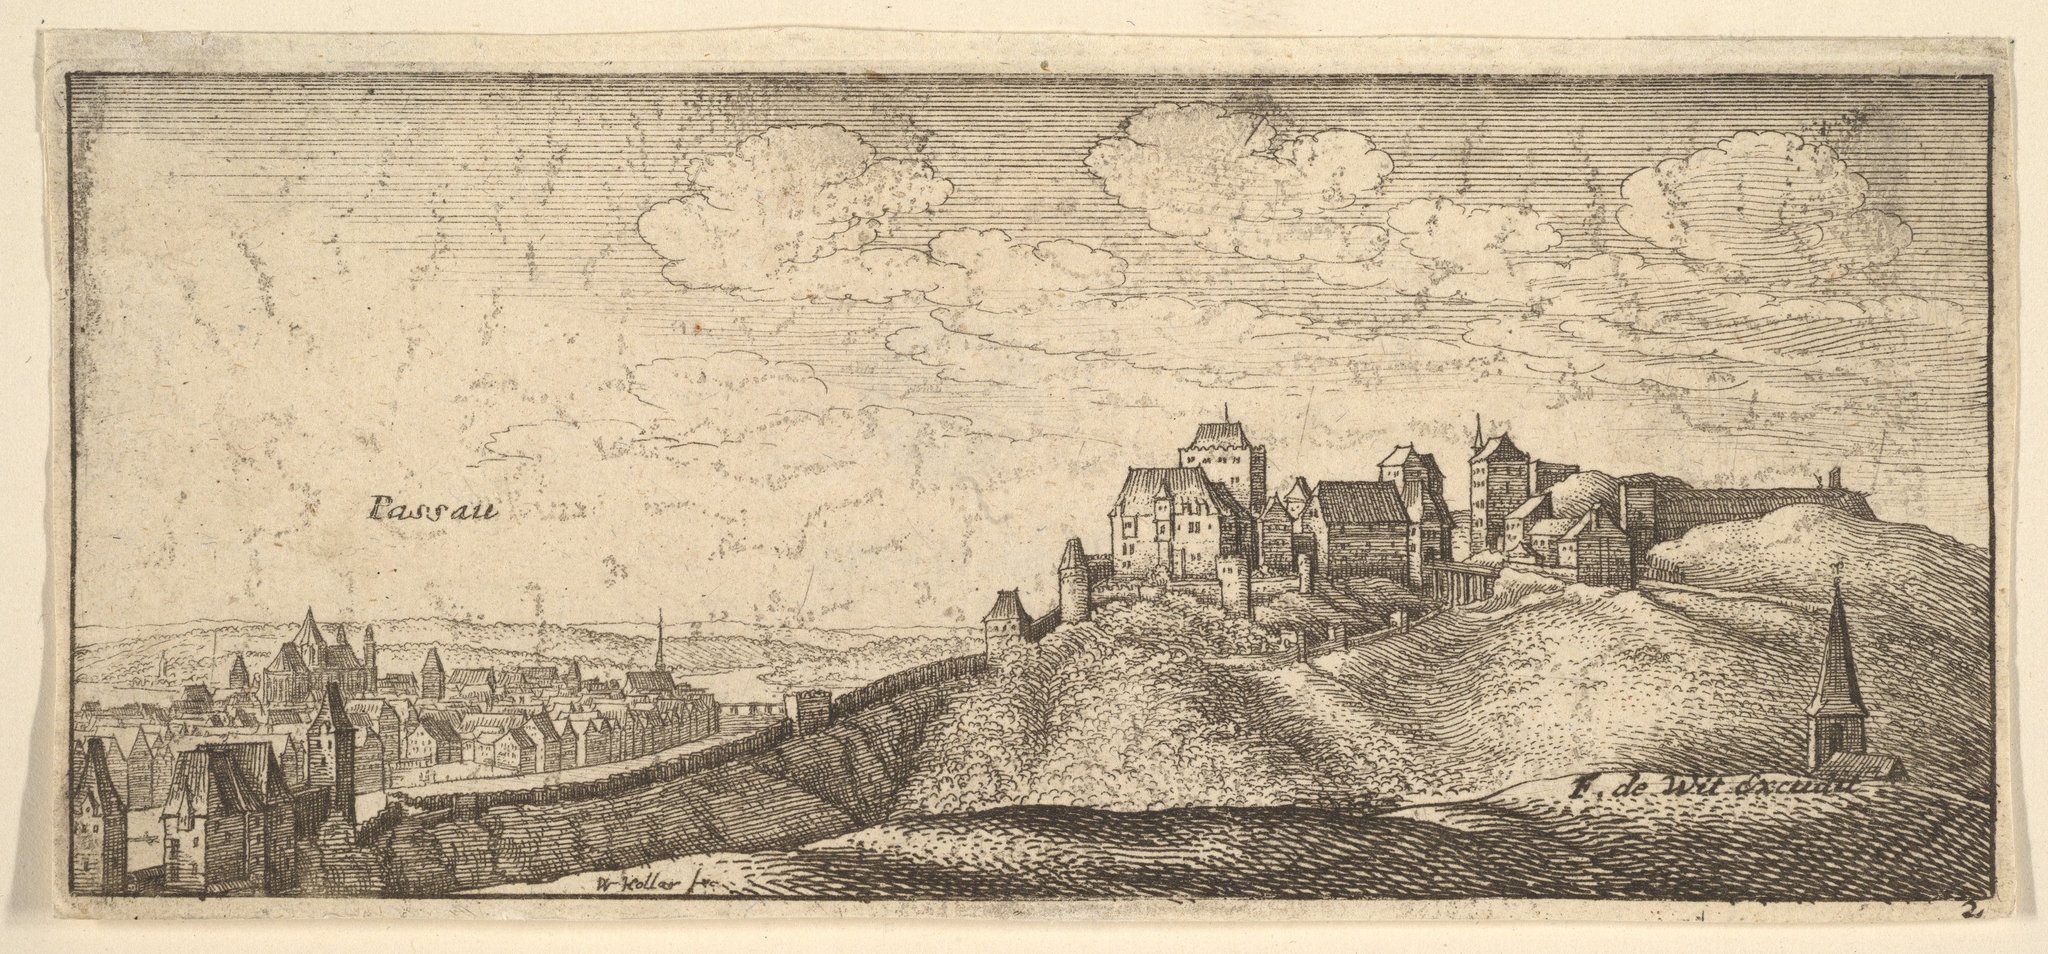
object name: print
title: Passau, from "German Views"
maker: wenceslaus hollar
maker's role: artist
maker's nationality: bohemian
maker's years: 1607-1677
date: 1652-1677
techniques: etching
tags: castles,towns